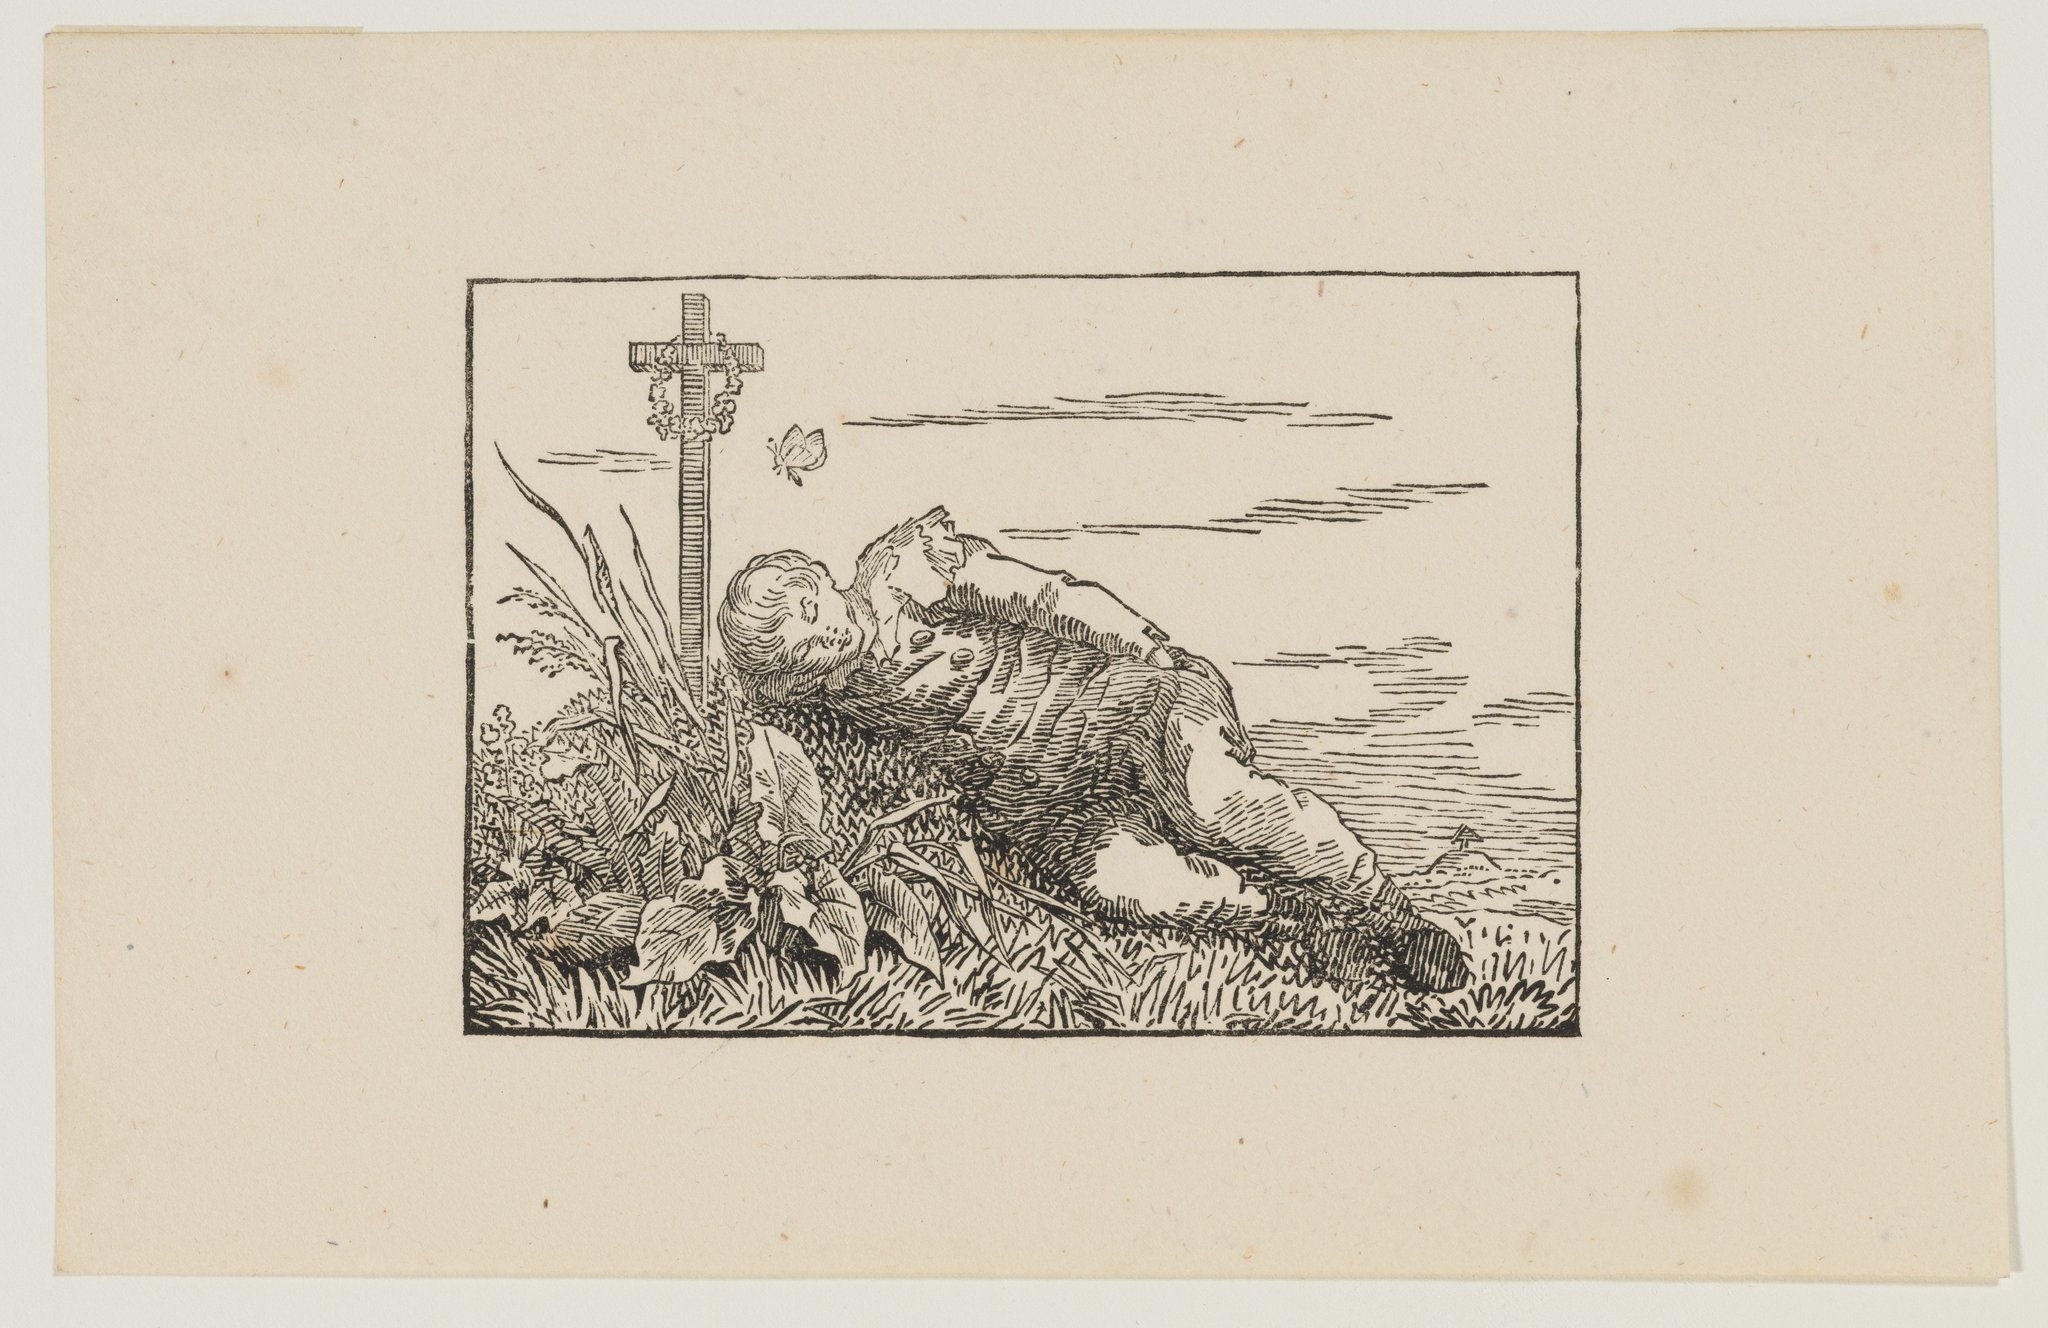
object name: print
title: Boy Sleeping on a Grave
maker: christian friedrich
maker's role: artist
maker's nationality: german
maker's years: 1779-1843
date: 1803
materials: paper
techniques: woodcut